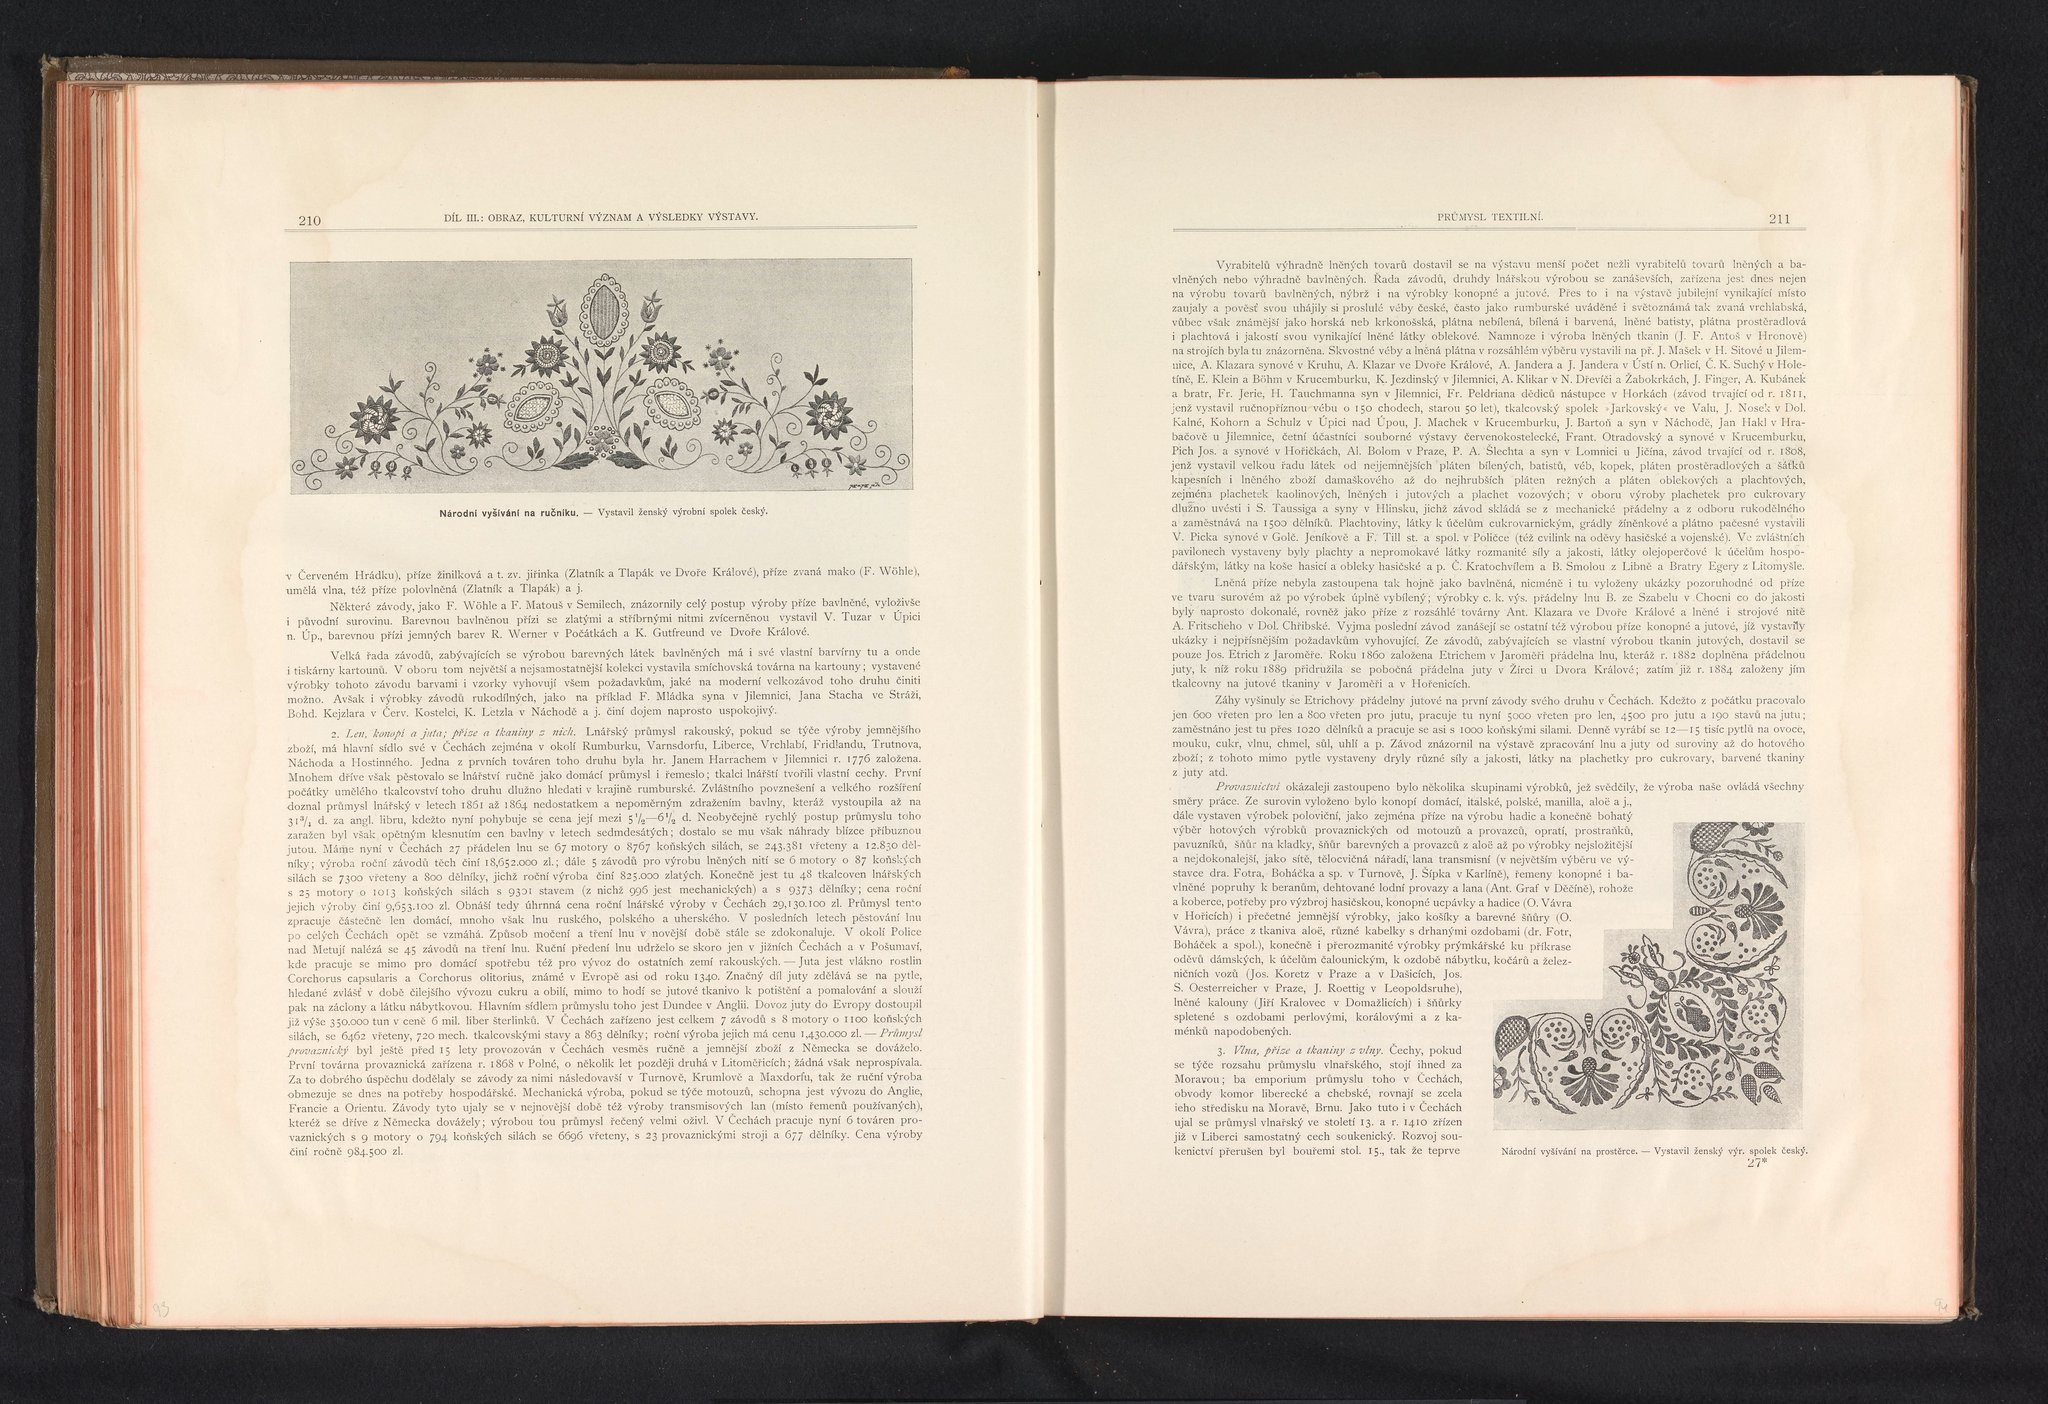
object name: page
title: Narodni vysiváni na rucniku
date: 1890-1895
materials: paper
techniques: autotype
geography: prague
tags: flowers, towel